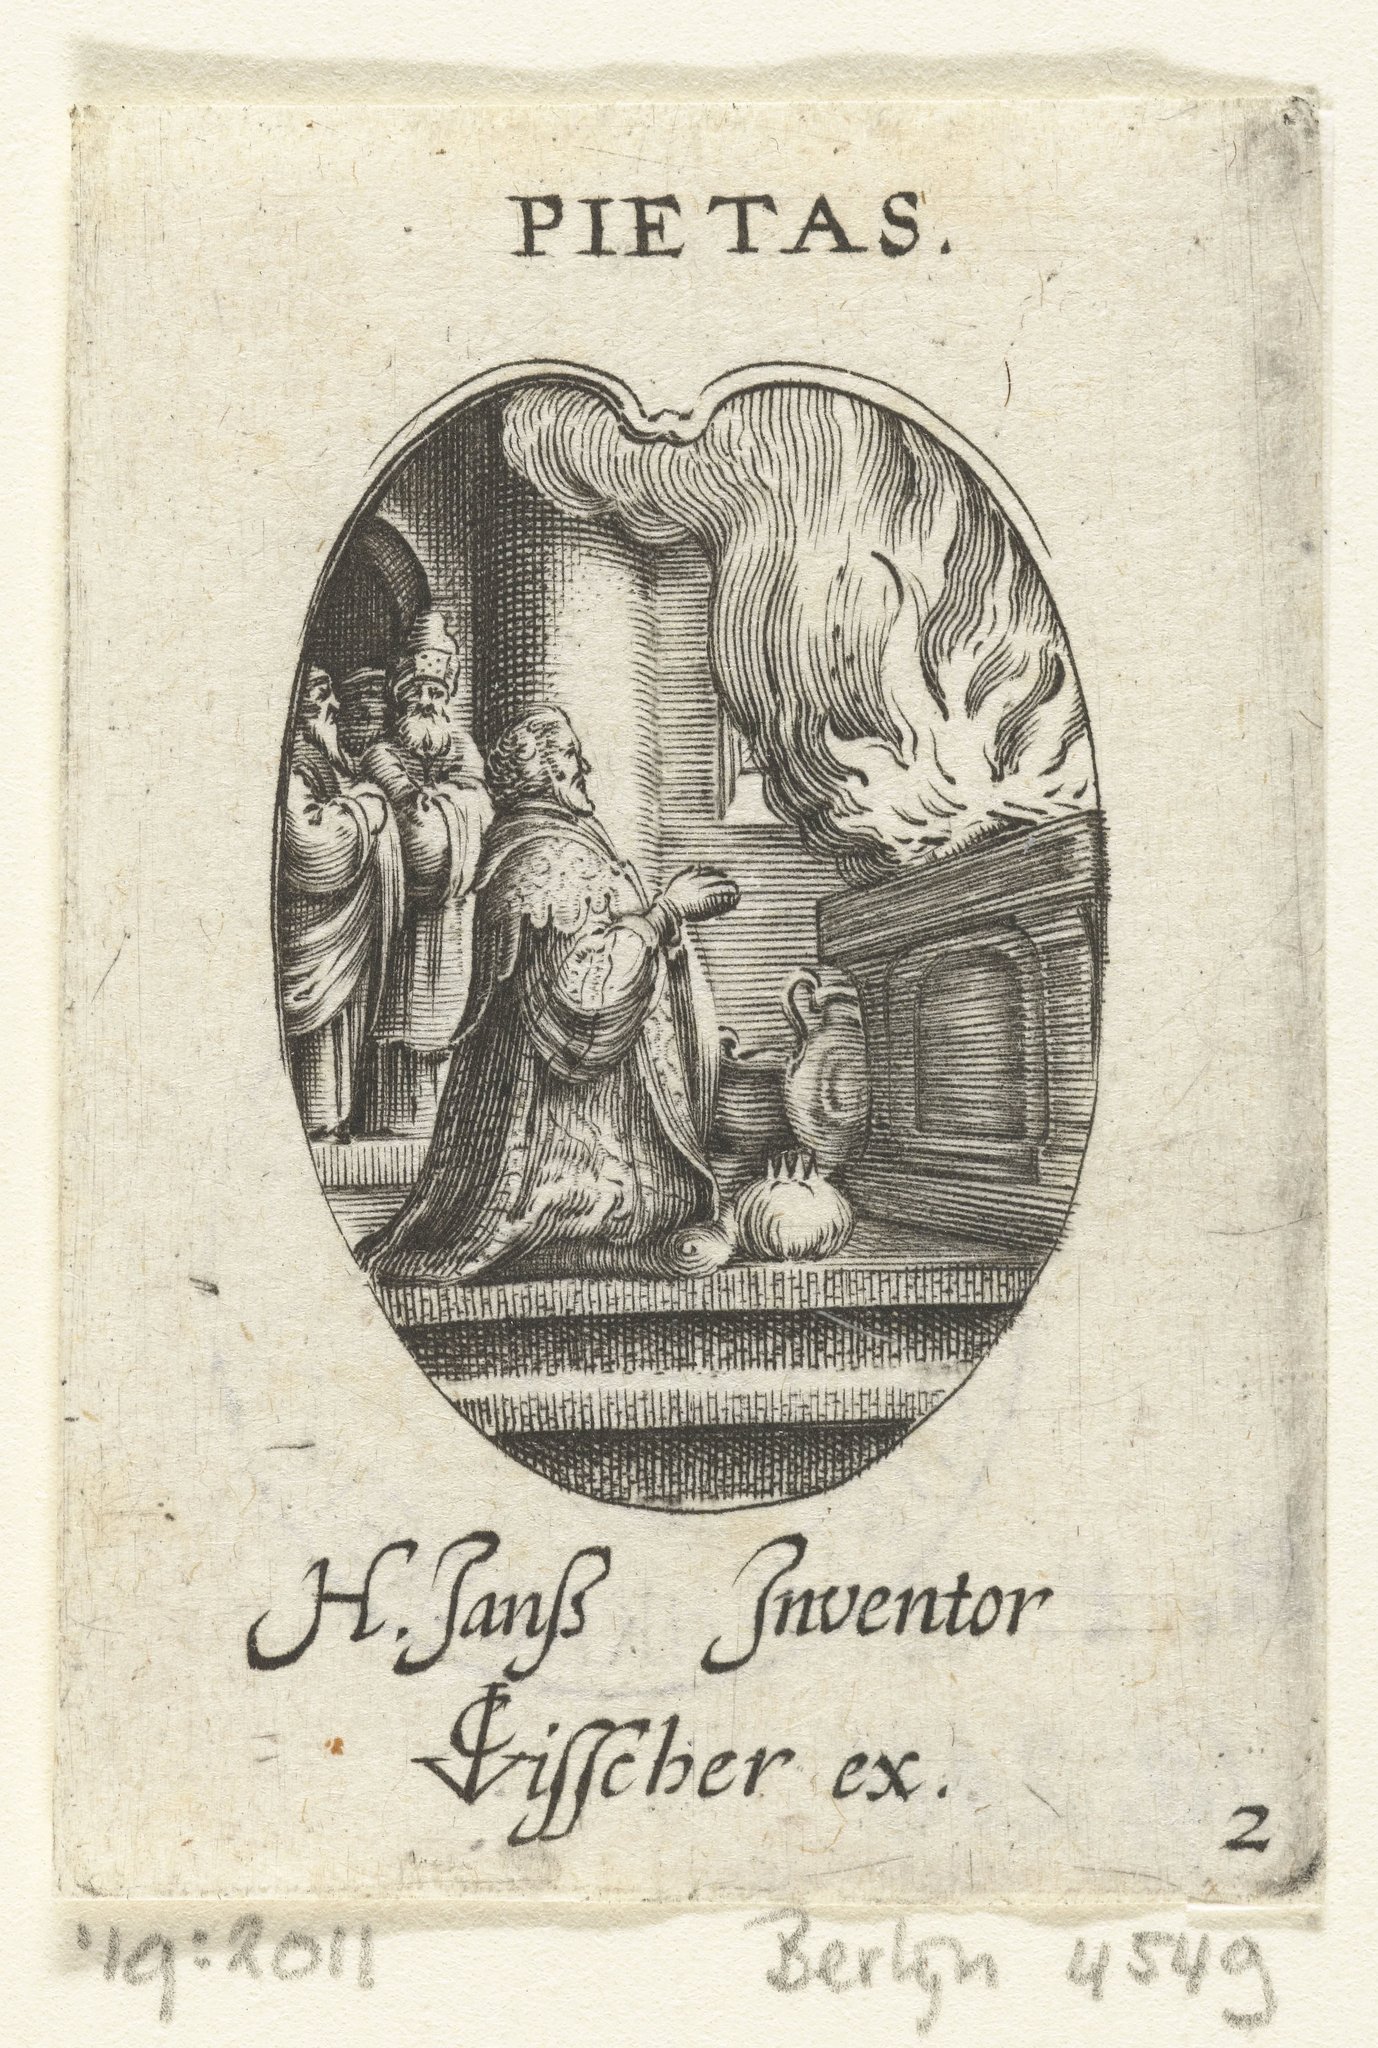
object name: print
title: Kleine ovalen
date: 1600-1699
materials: paper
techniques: engraving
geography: amsterdam